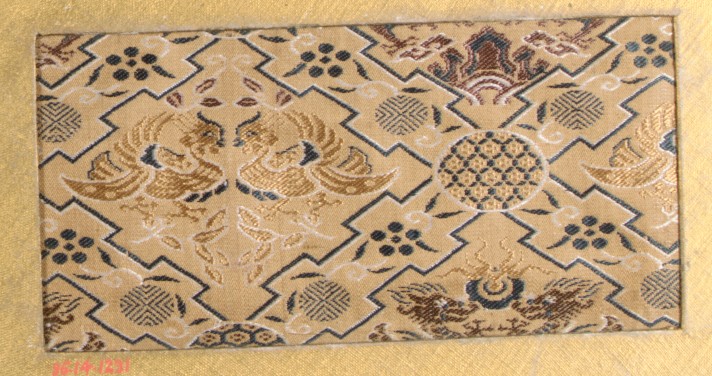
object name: piece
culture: japanese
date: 1701-1900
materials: silk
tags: dragons